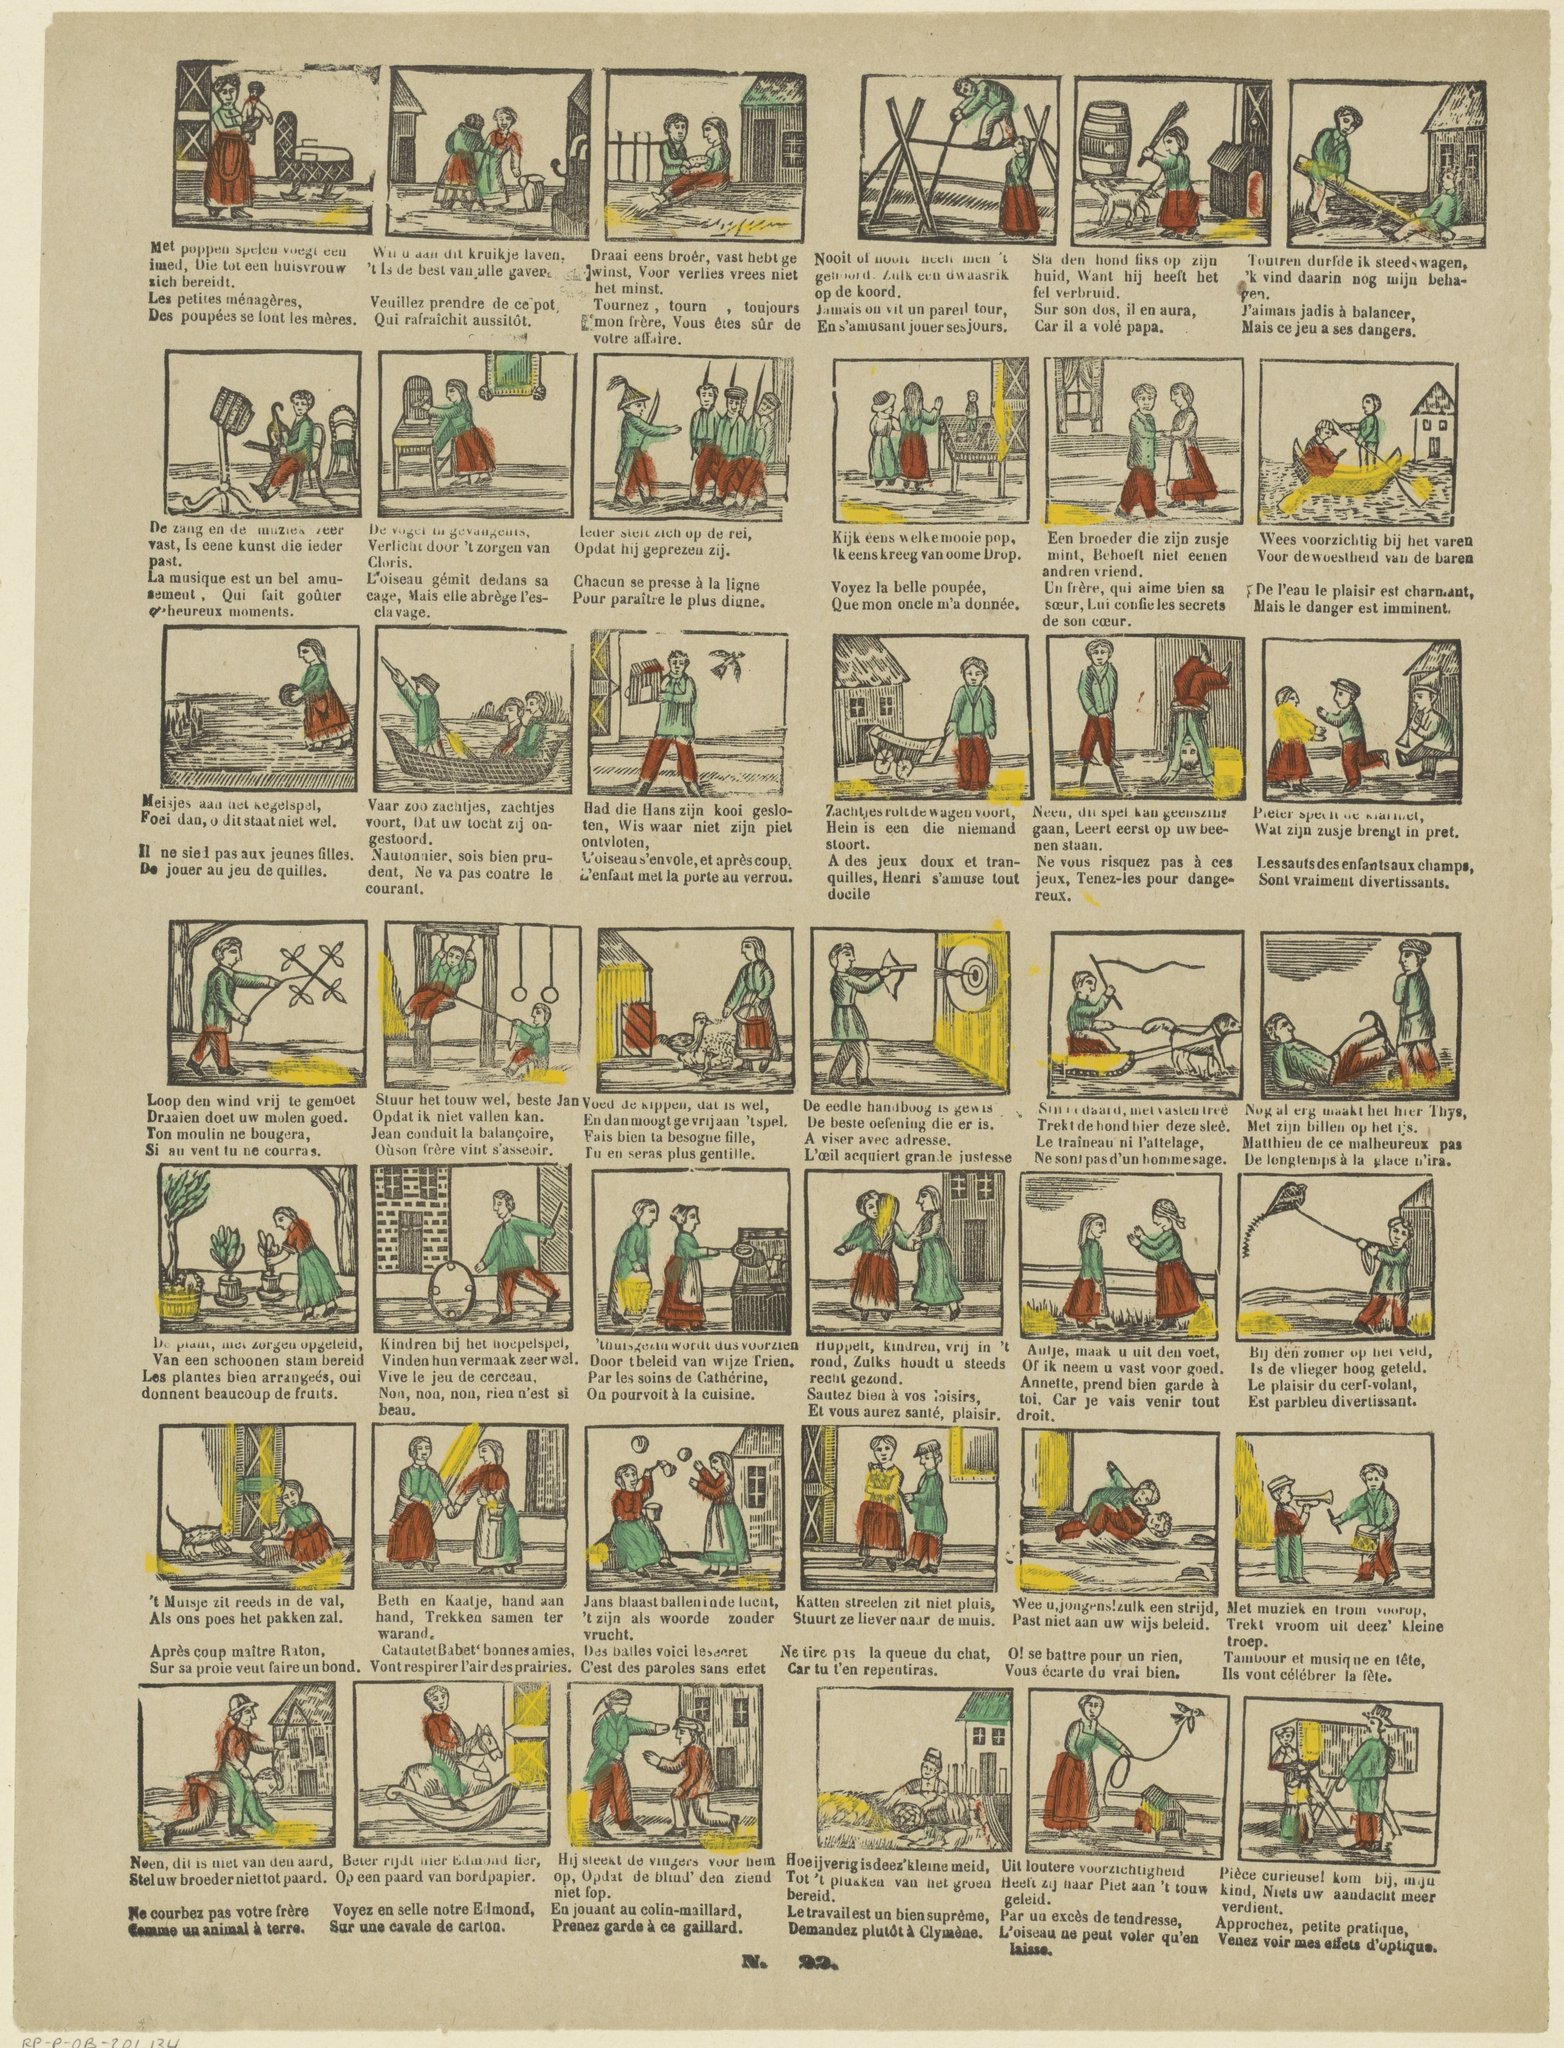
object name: popular print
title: Kinderspelen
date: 1866-1902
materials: paper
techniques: colour, letterpress printing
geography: turnhout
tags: bubble-blowing (children's games and plays), children's games and plays, child, swinging (children's game), games using special objects (marbles, top, hoop, etc.), seesaw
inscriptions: collector's mark: Lugt 2760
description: Blad met 42 voorstellingen van kinderspelen, bijvoorbeeld wippen, schommelen, hoepelen, bellenblazen en muziek maken. Onder elke afbeelding een tweeregelig vers in het Nederlands en in het Frans. Genummerd midden onder: N. 22.